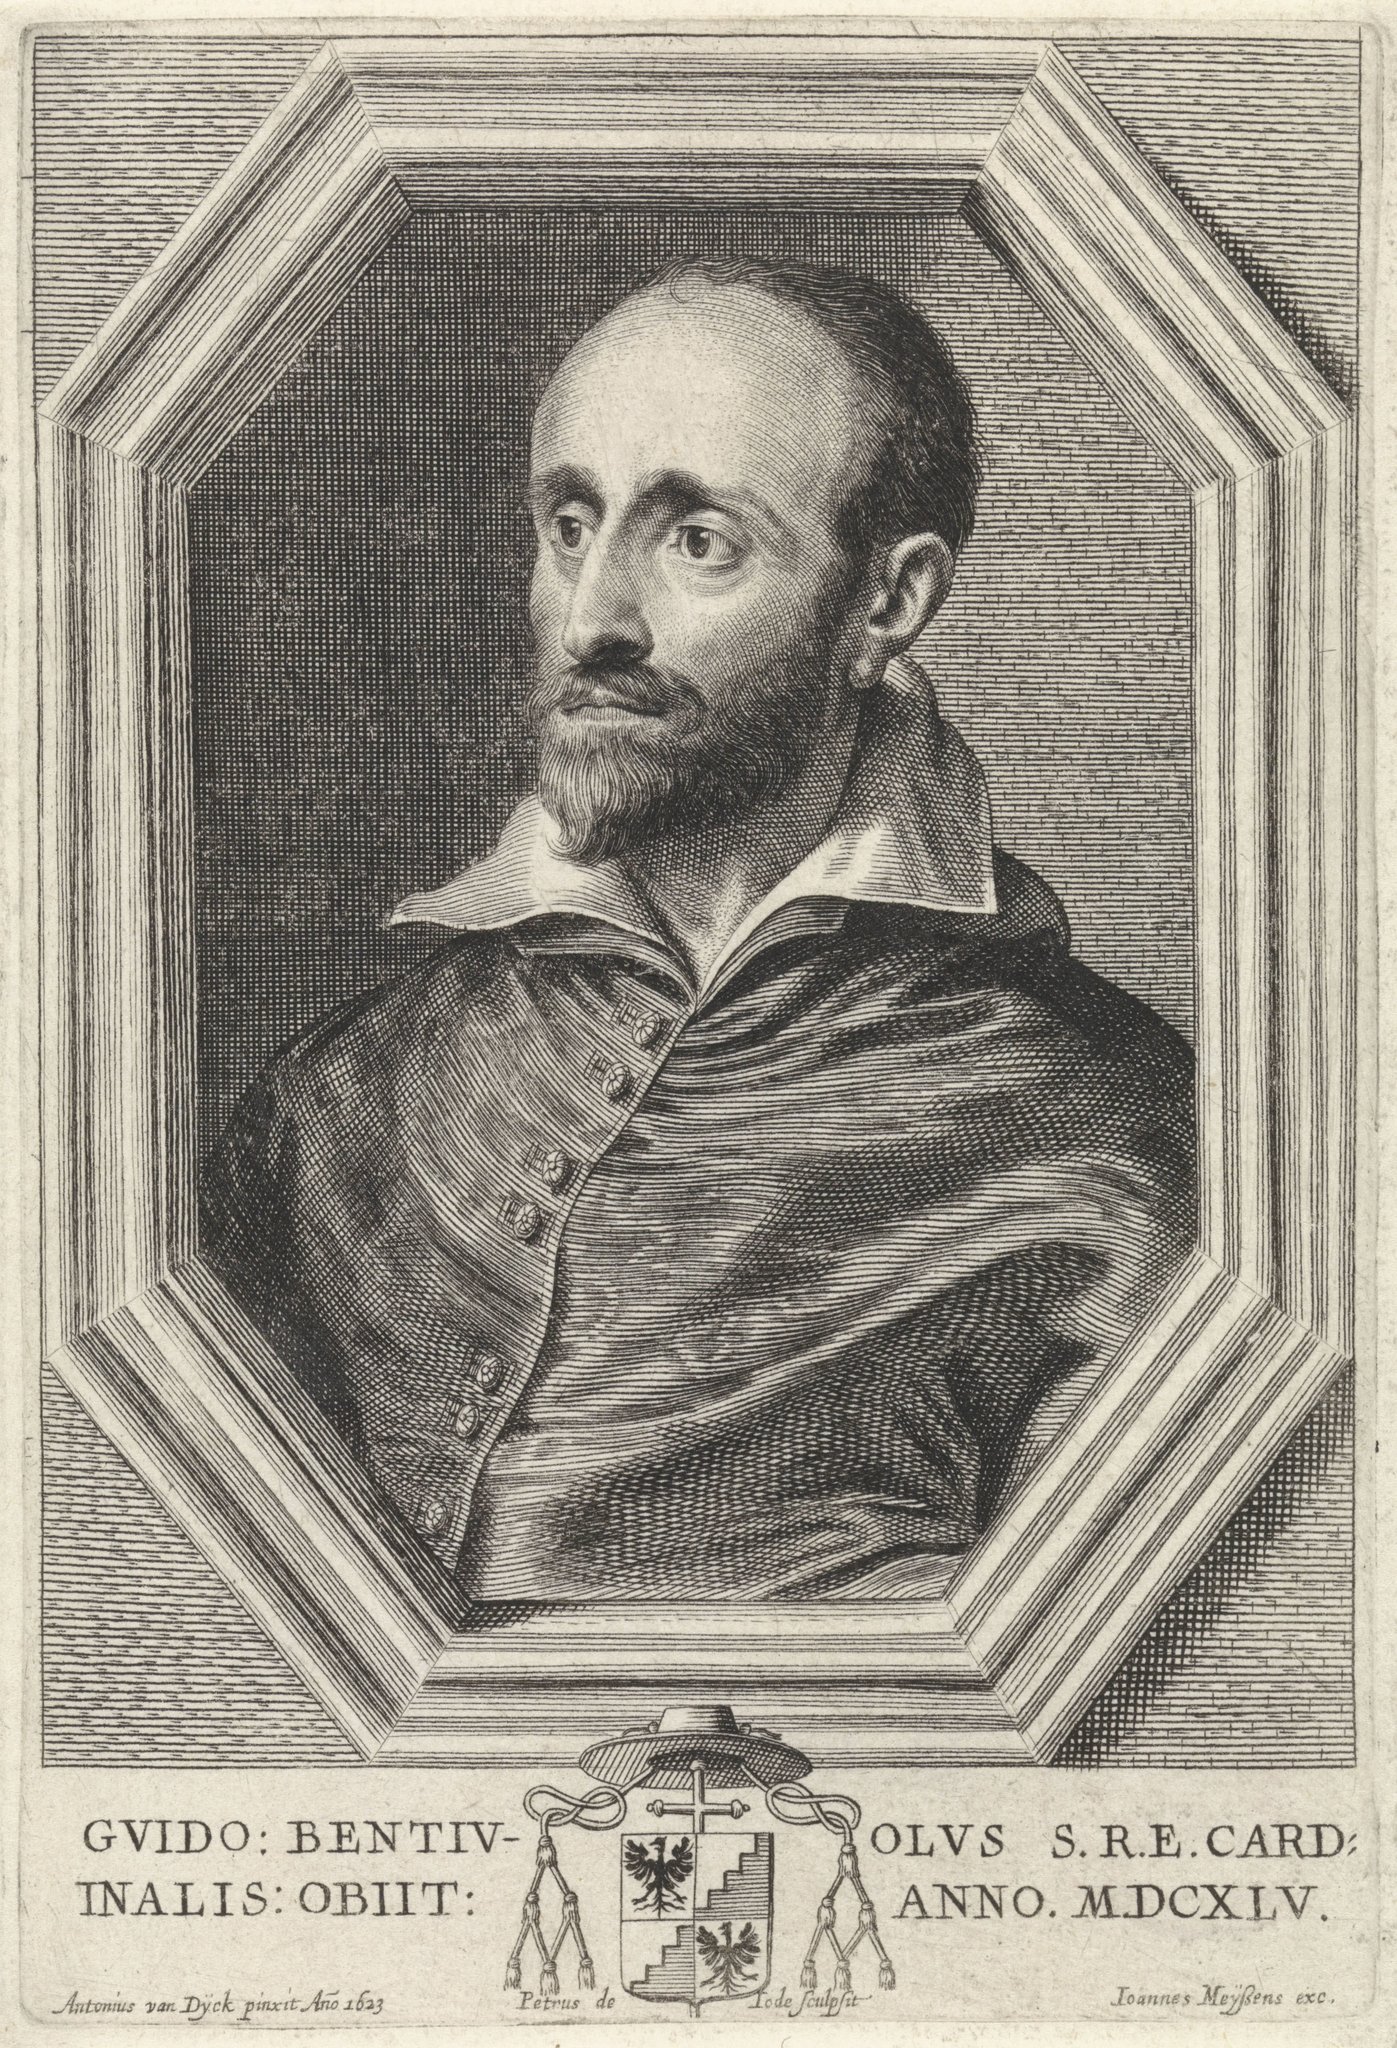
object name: print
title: Theater van bisschoppen, keizers, koningen, hertogen, prinsen, enz.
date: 1628-1670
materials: paper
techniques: engraving, etching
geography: antwerp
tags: politician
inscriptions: collector's mark: Lugt 240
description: Busteportret van kardinaal Guido Bentivoglio. Het portret is gevat in een achthoekige omlijsting. In de marge zijn wapenschild en een tweeregelig onderschrift in het Latijn.